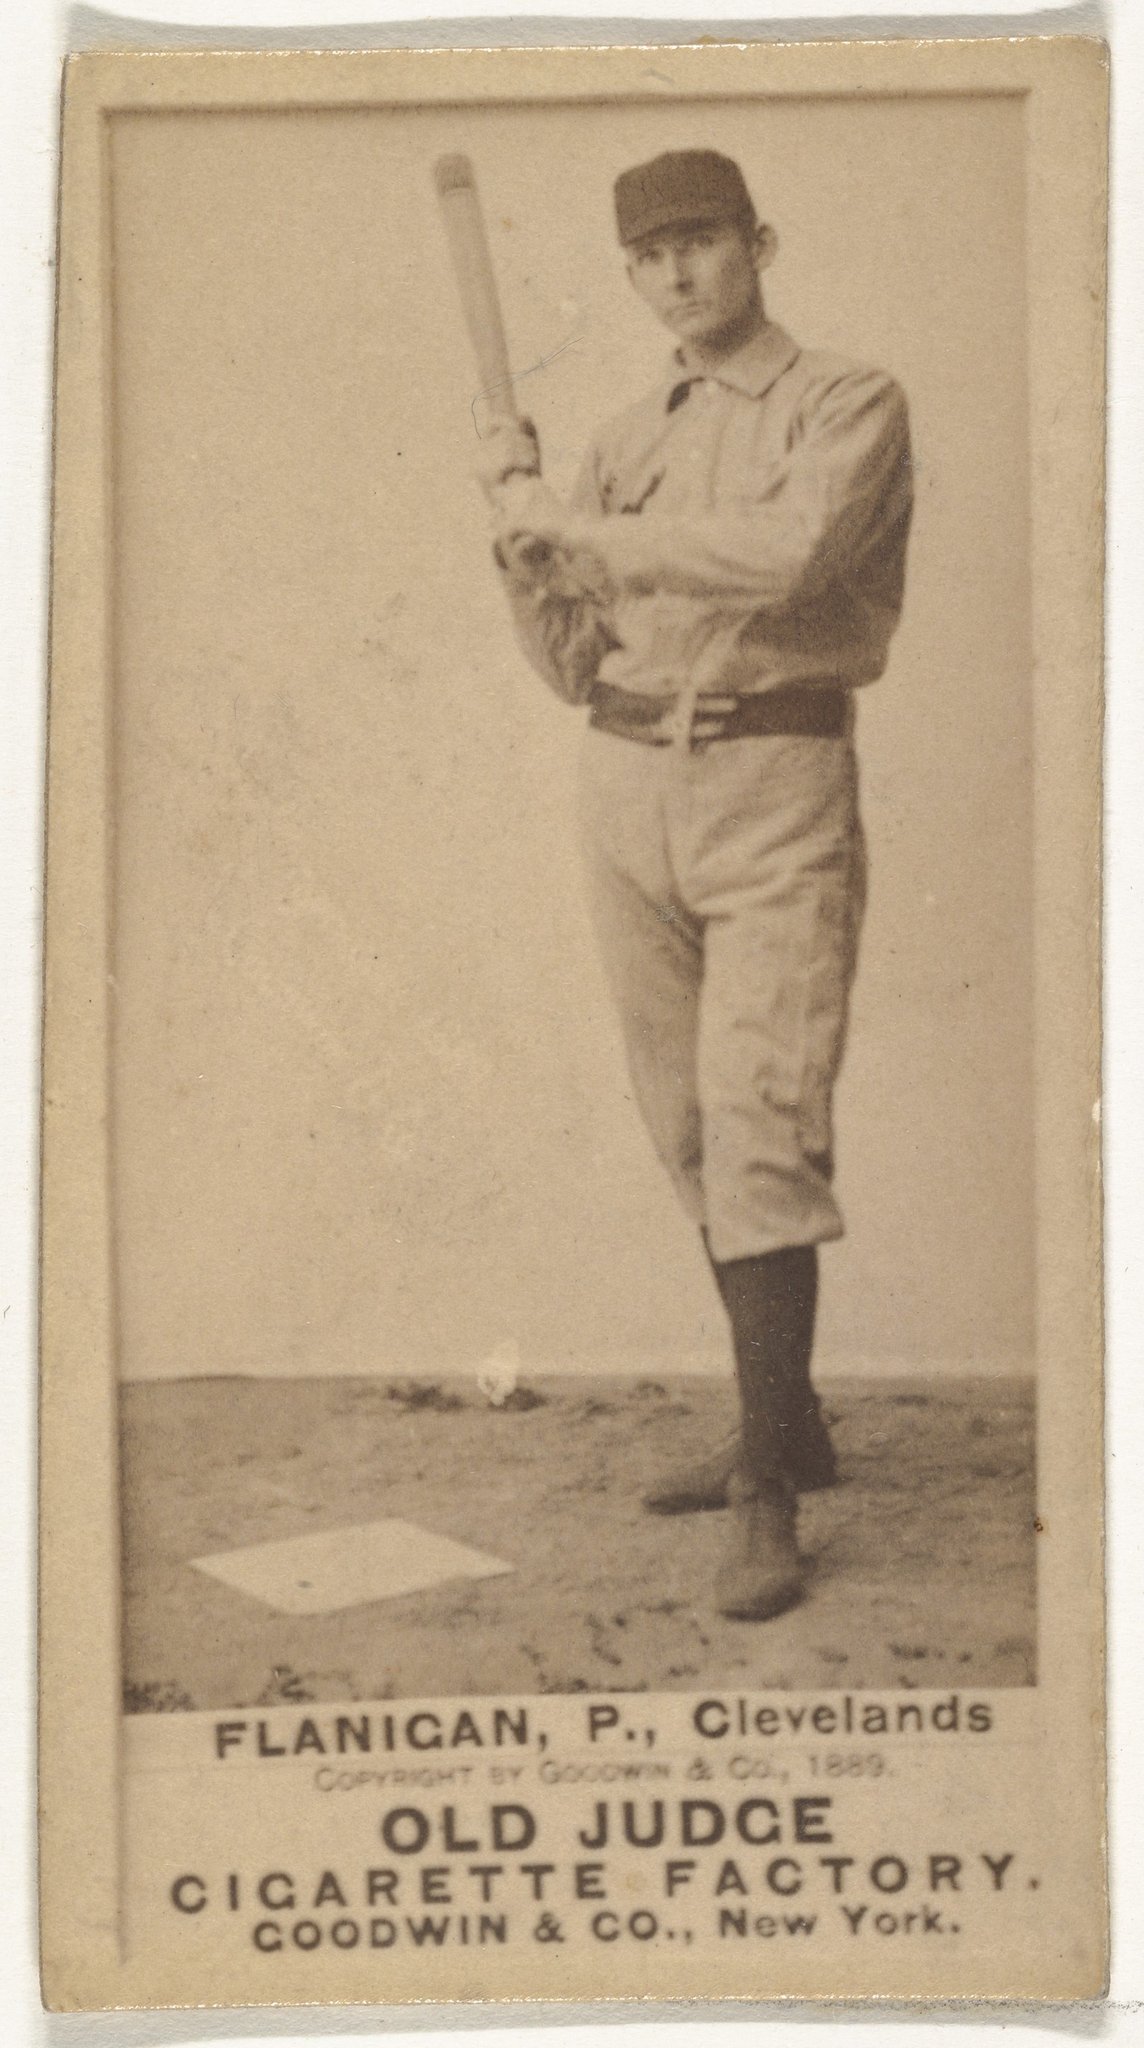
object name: baseball card, photograph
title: Flanigan, Pitcher, Cleveland, from the Old Judge series (N172) for Old Judge Cigarettes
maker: goodwin & company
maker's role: publisher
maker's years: 1850-1950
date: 1889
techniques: albumen silver print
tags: men,portraits,baseball,athletes